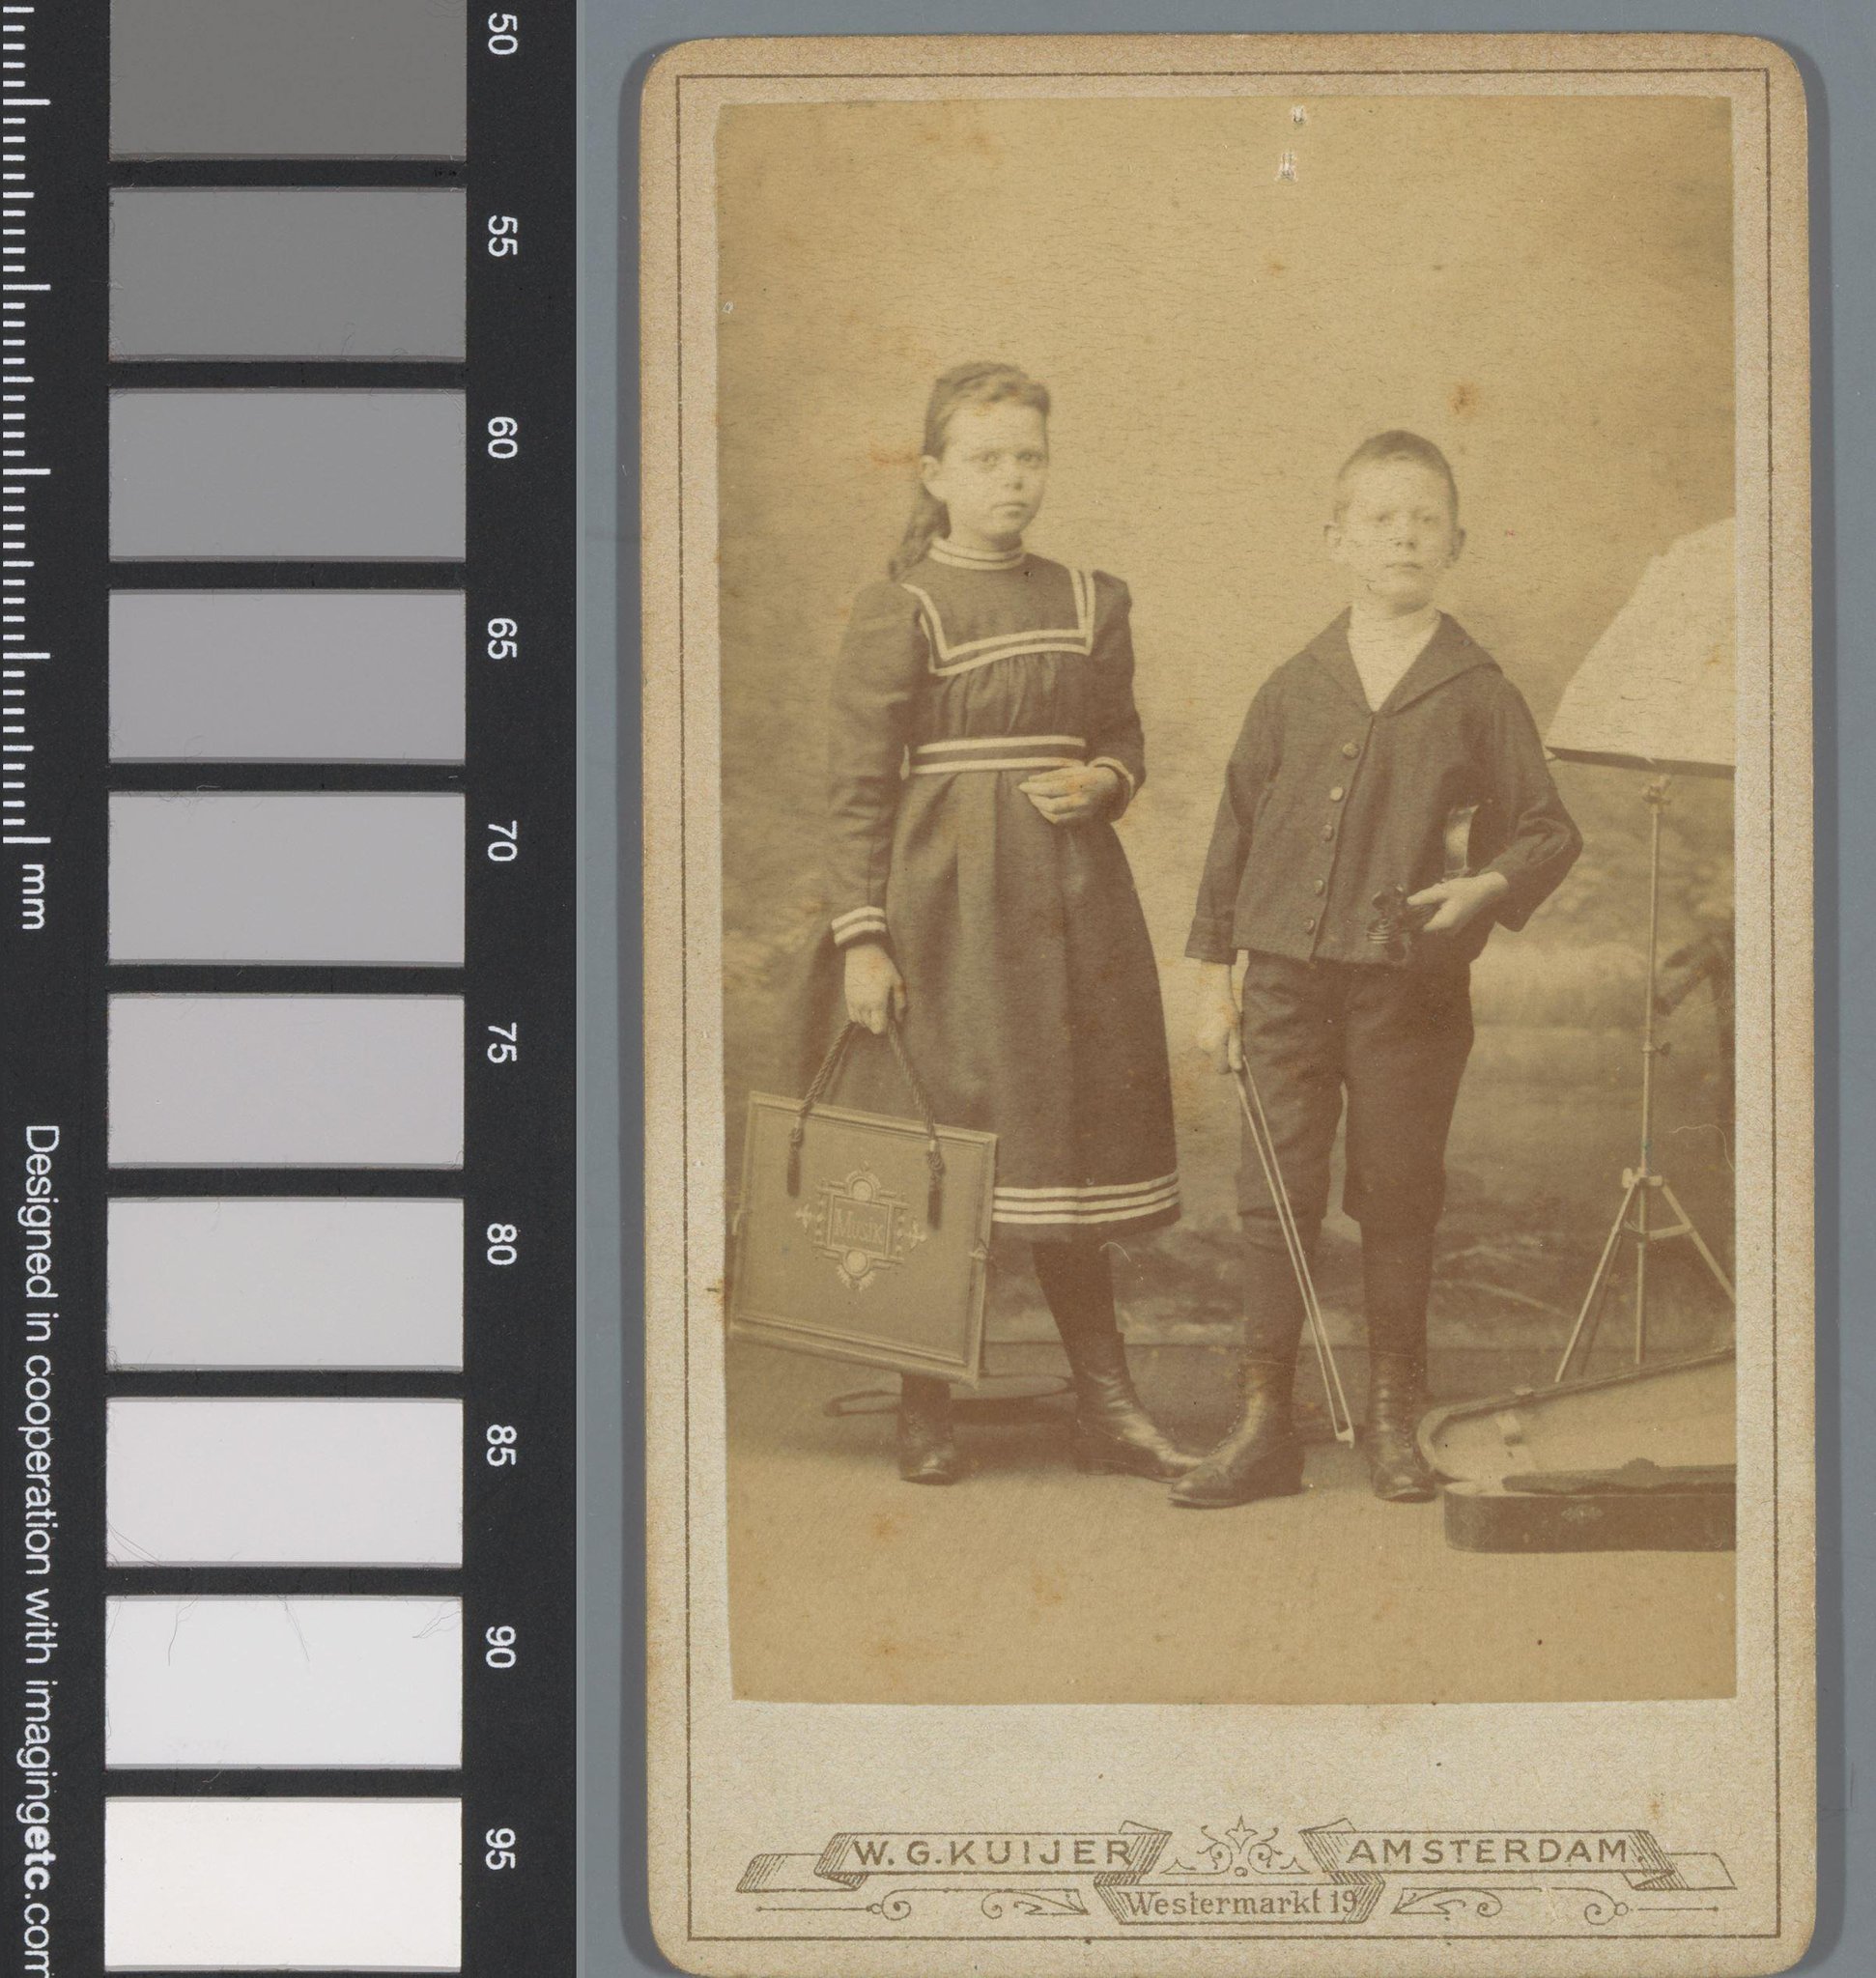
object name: photograph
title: Portret van een onbekend meisje en een onbekende jongen met een viool onder zijn arm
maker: willem gerhardus kuijer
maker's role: fotograaf, hoffotograaf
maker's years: 1834-1899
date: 1862-1899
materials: cardboard, paper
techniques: albumen print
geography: amsterdam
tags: boy (child between toddler and youth), historical persons, violin, fiddle, girl (child between toddler and youth)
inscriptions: inscription: ‘Photographie/ instantanée,/ W. G. Kuijer/ Westermarkt/ 19/ AMSTERDAM./ Speciale inrichting voor vergrootingen/ in alle formaten/ 1/ PRAGER & LOJDA BERLIN’